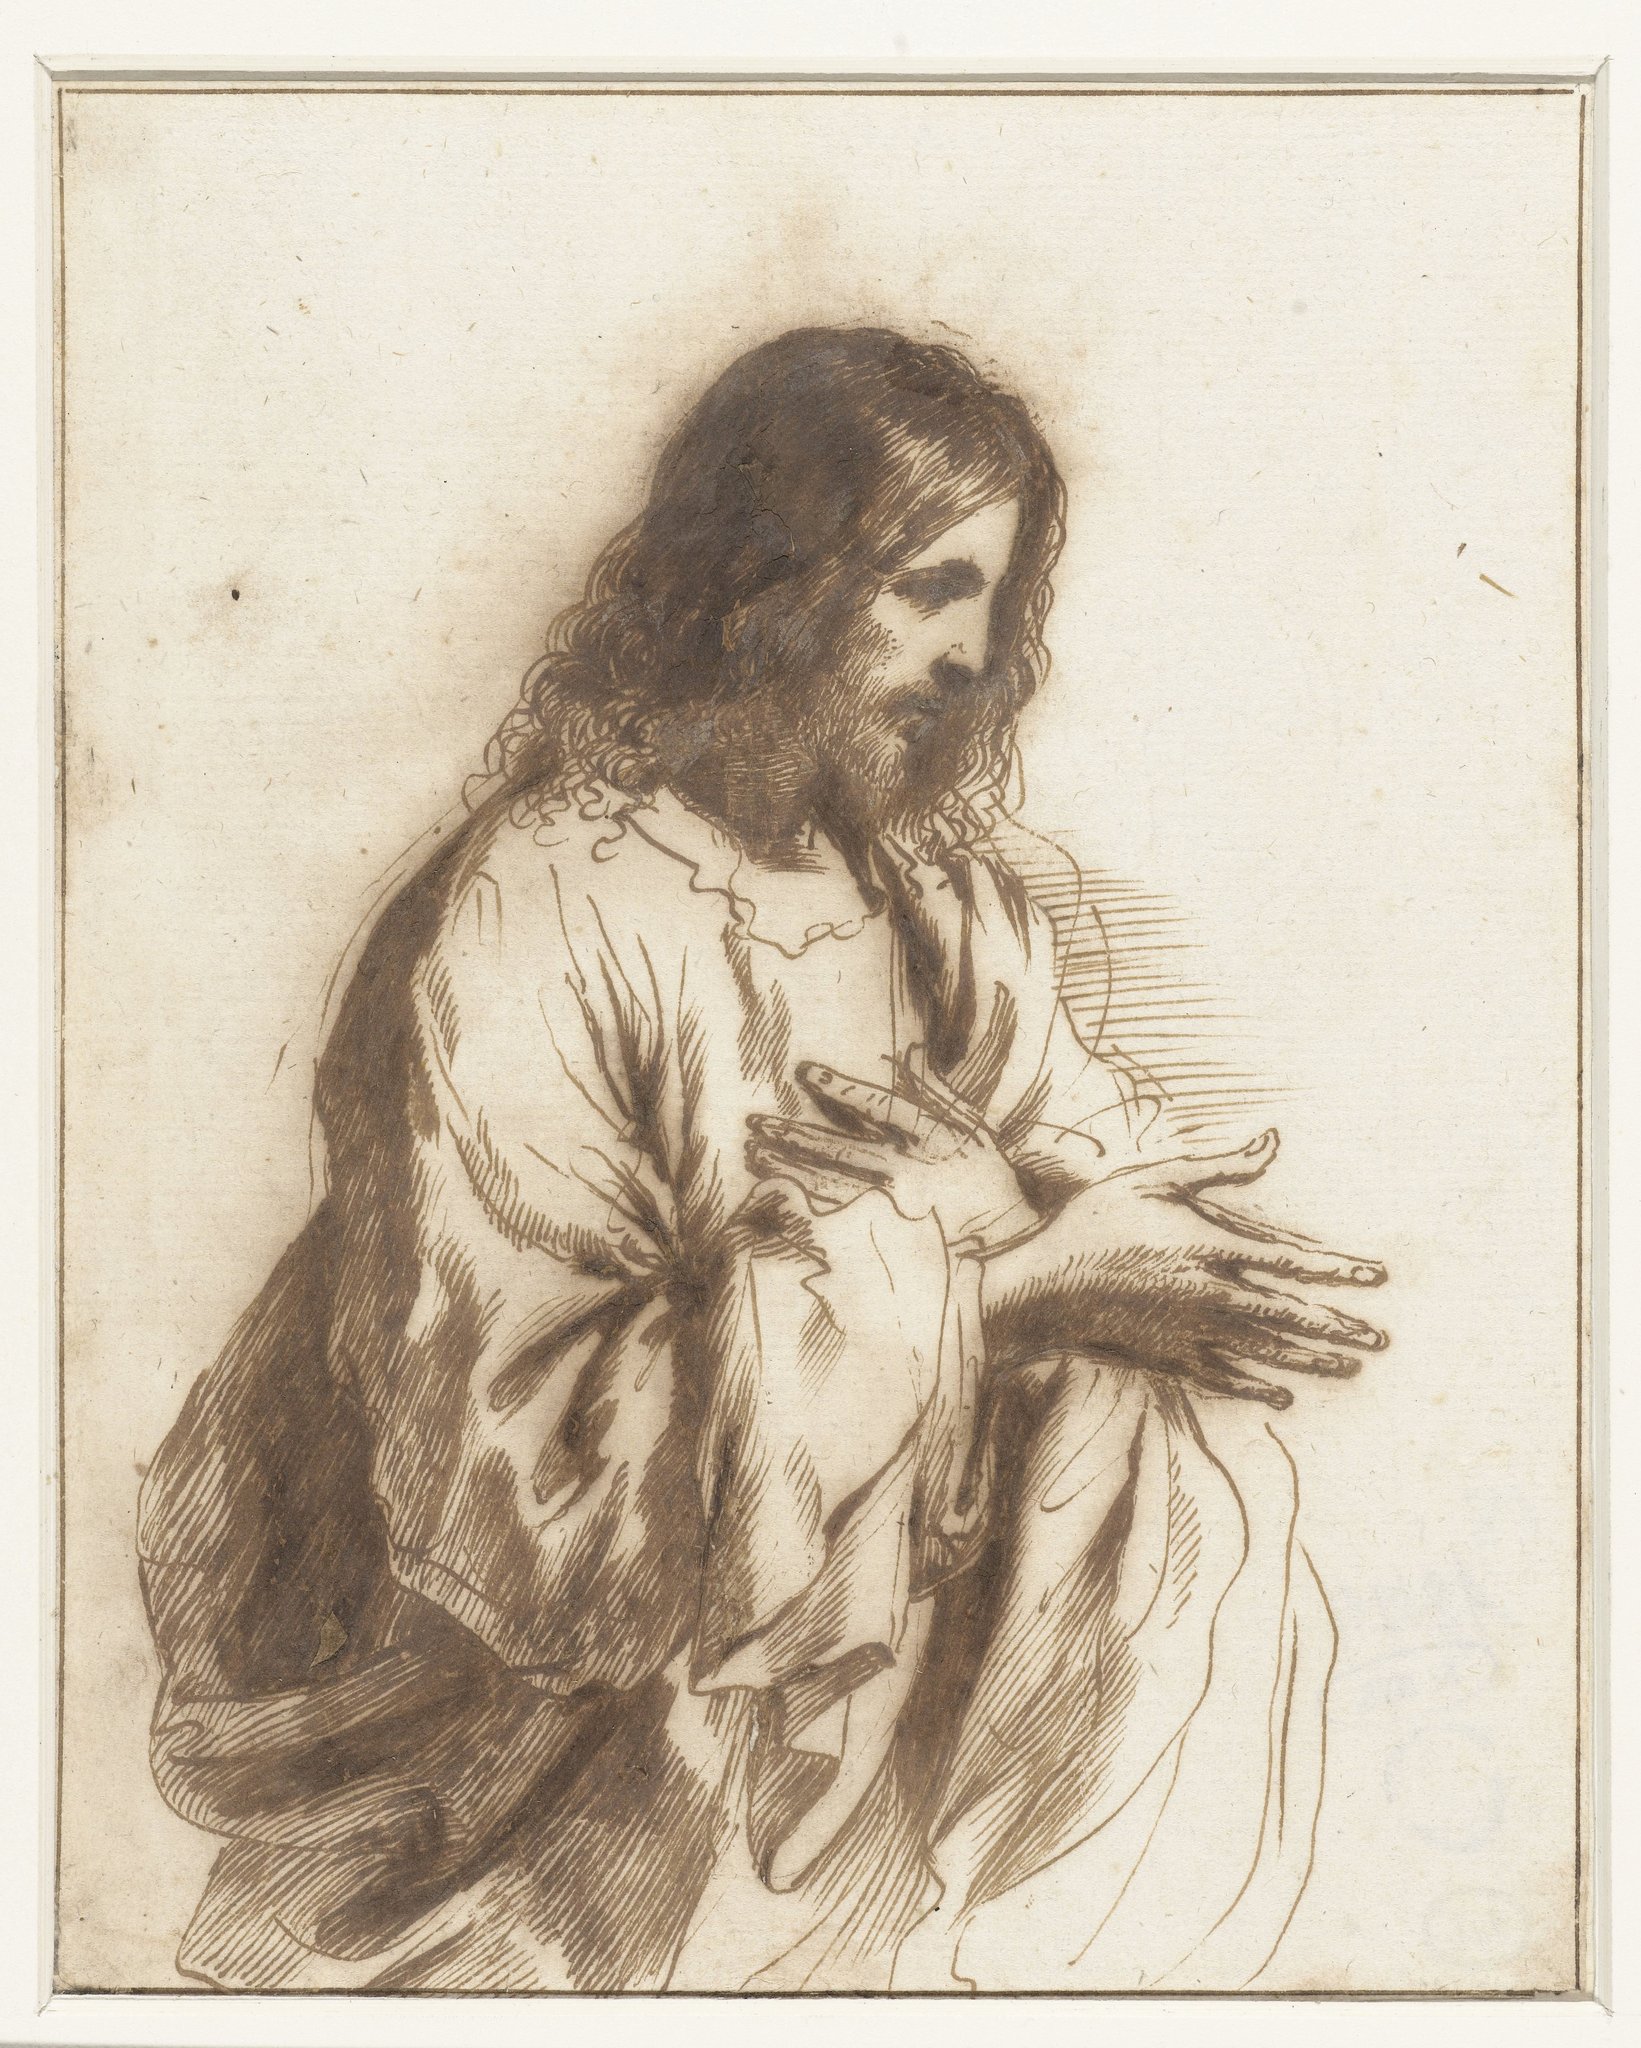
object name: drawing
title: Christus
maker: g.jo.franc da cento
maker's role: draughtsman, painter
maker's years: 1591-1666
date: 1601-1666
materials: ink, paper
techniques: pen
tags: christ as adult